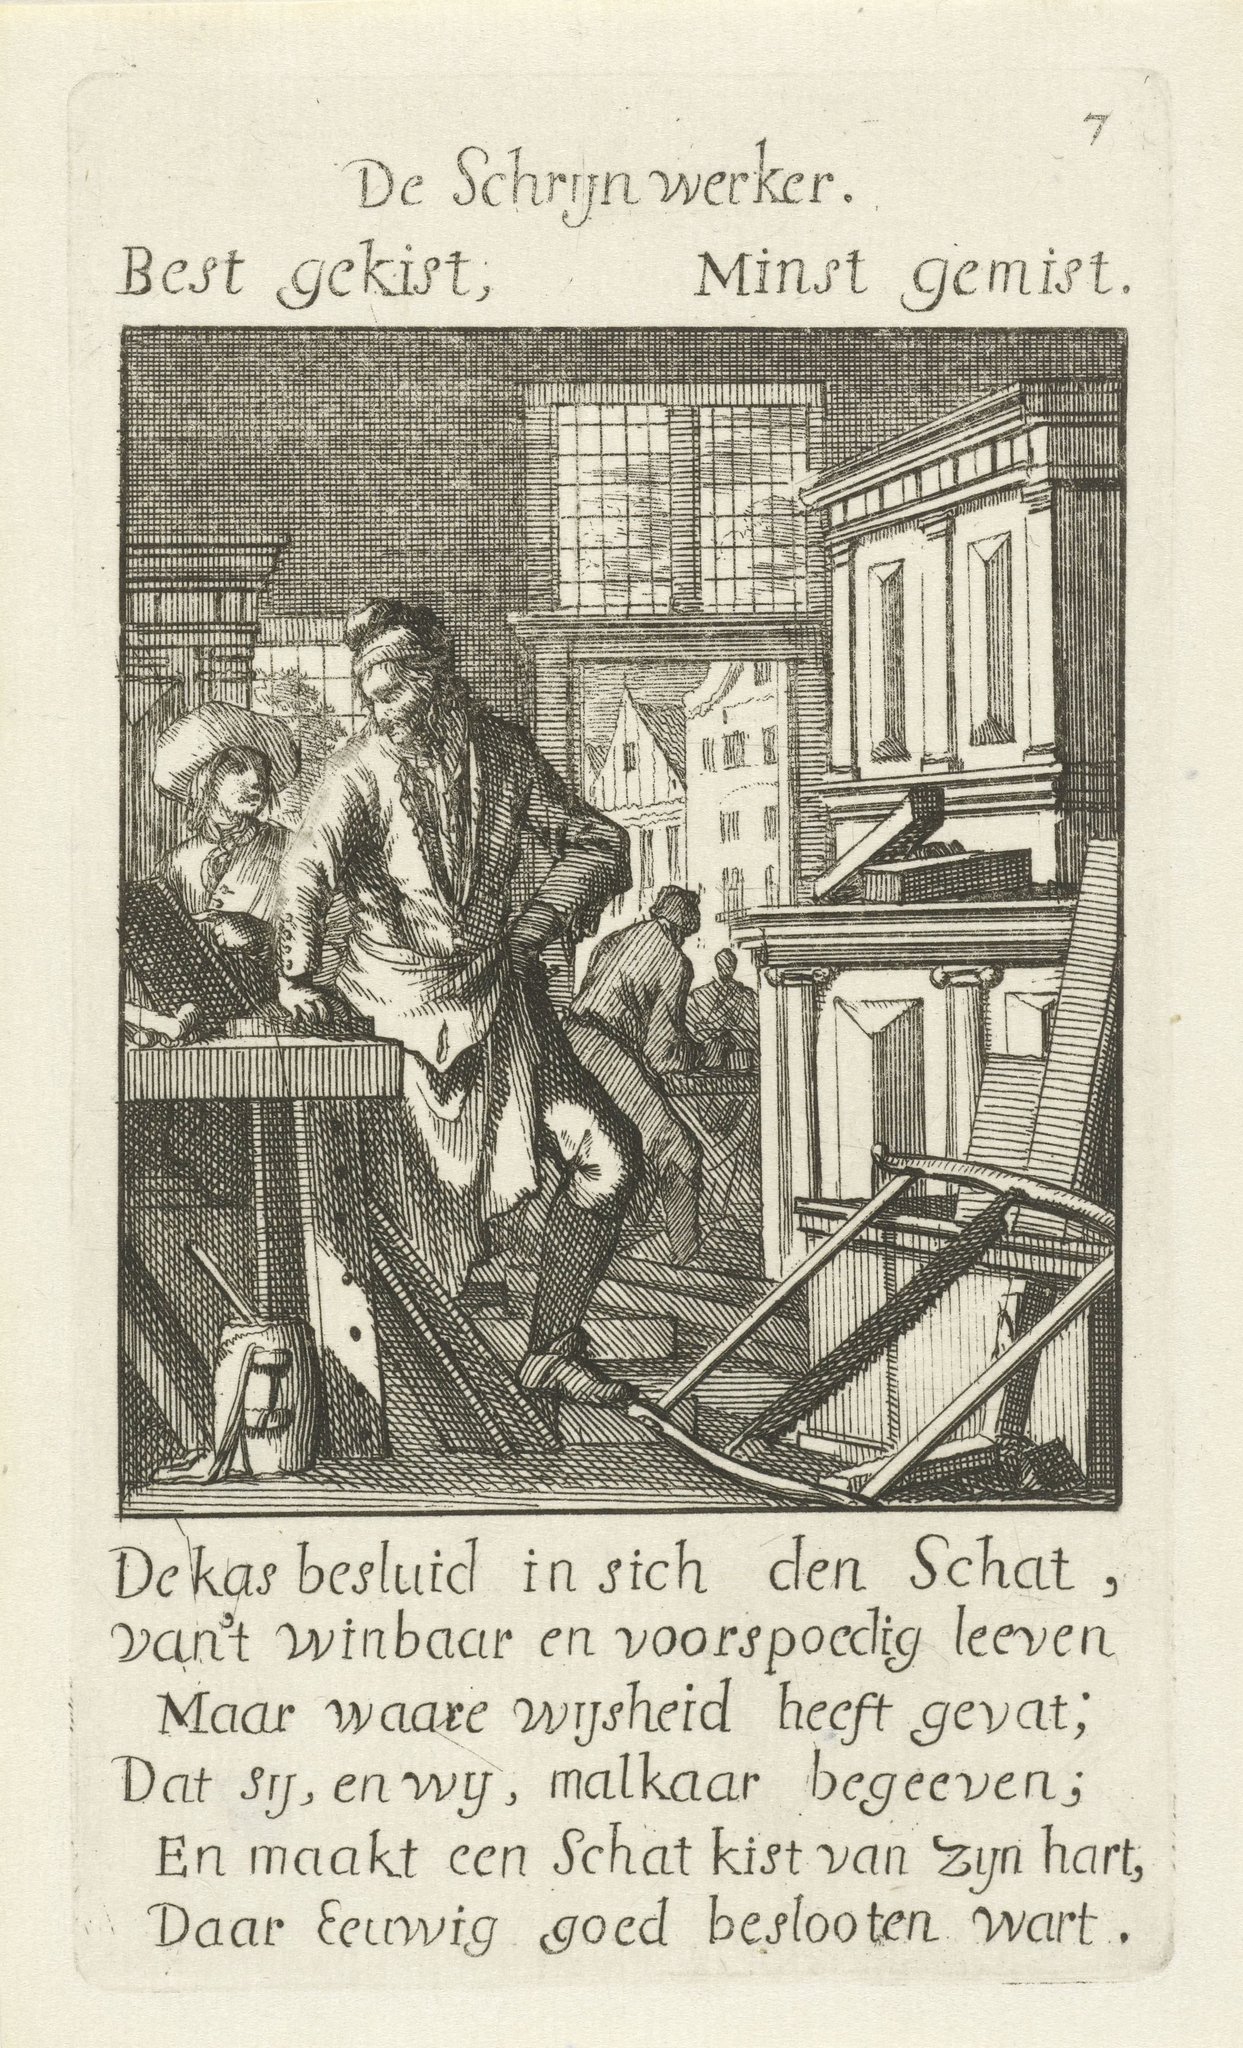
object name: print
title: Schrijnwerker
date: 1694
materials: paper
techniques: etching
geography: amsterdam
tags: joiner, cabinet maker, 'ébéniste', handicrafts, craftsman at work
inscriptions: collector's mark: Lugt 2228, collector's mark: Lugt 2760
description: Maakt deel uit van de 100-delige serie beroepsprenten van Jan en Caspar Luyken, getiteld: Het menselyk bedryf. S.l.s.n., 1694 (eerste druk).